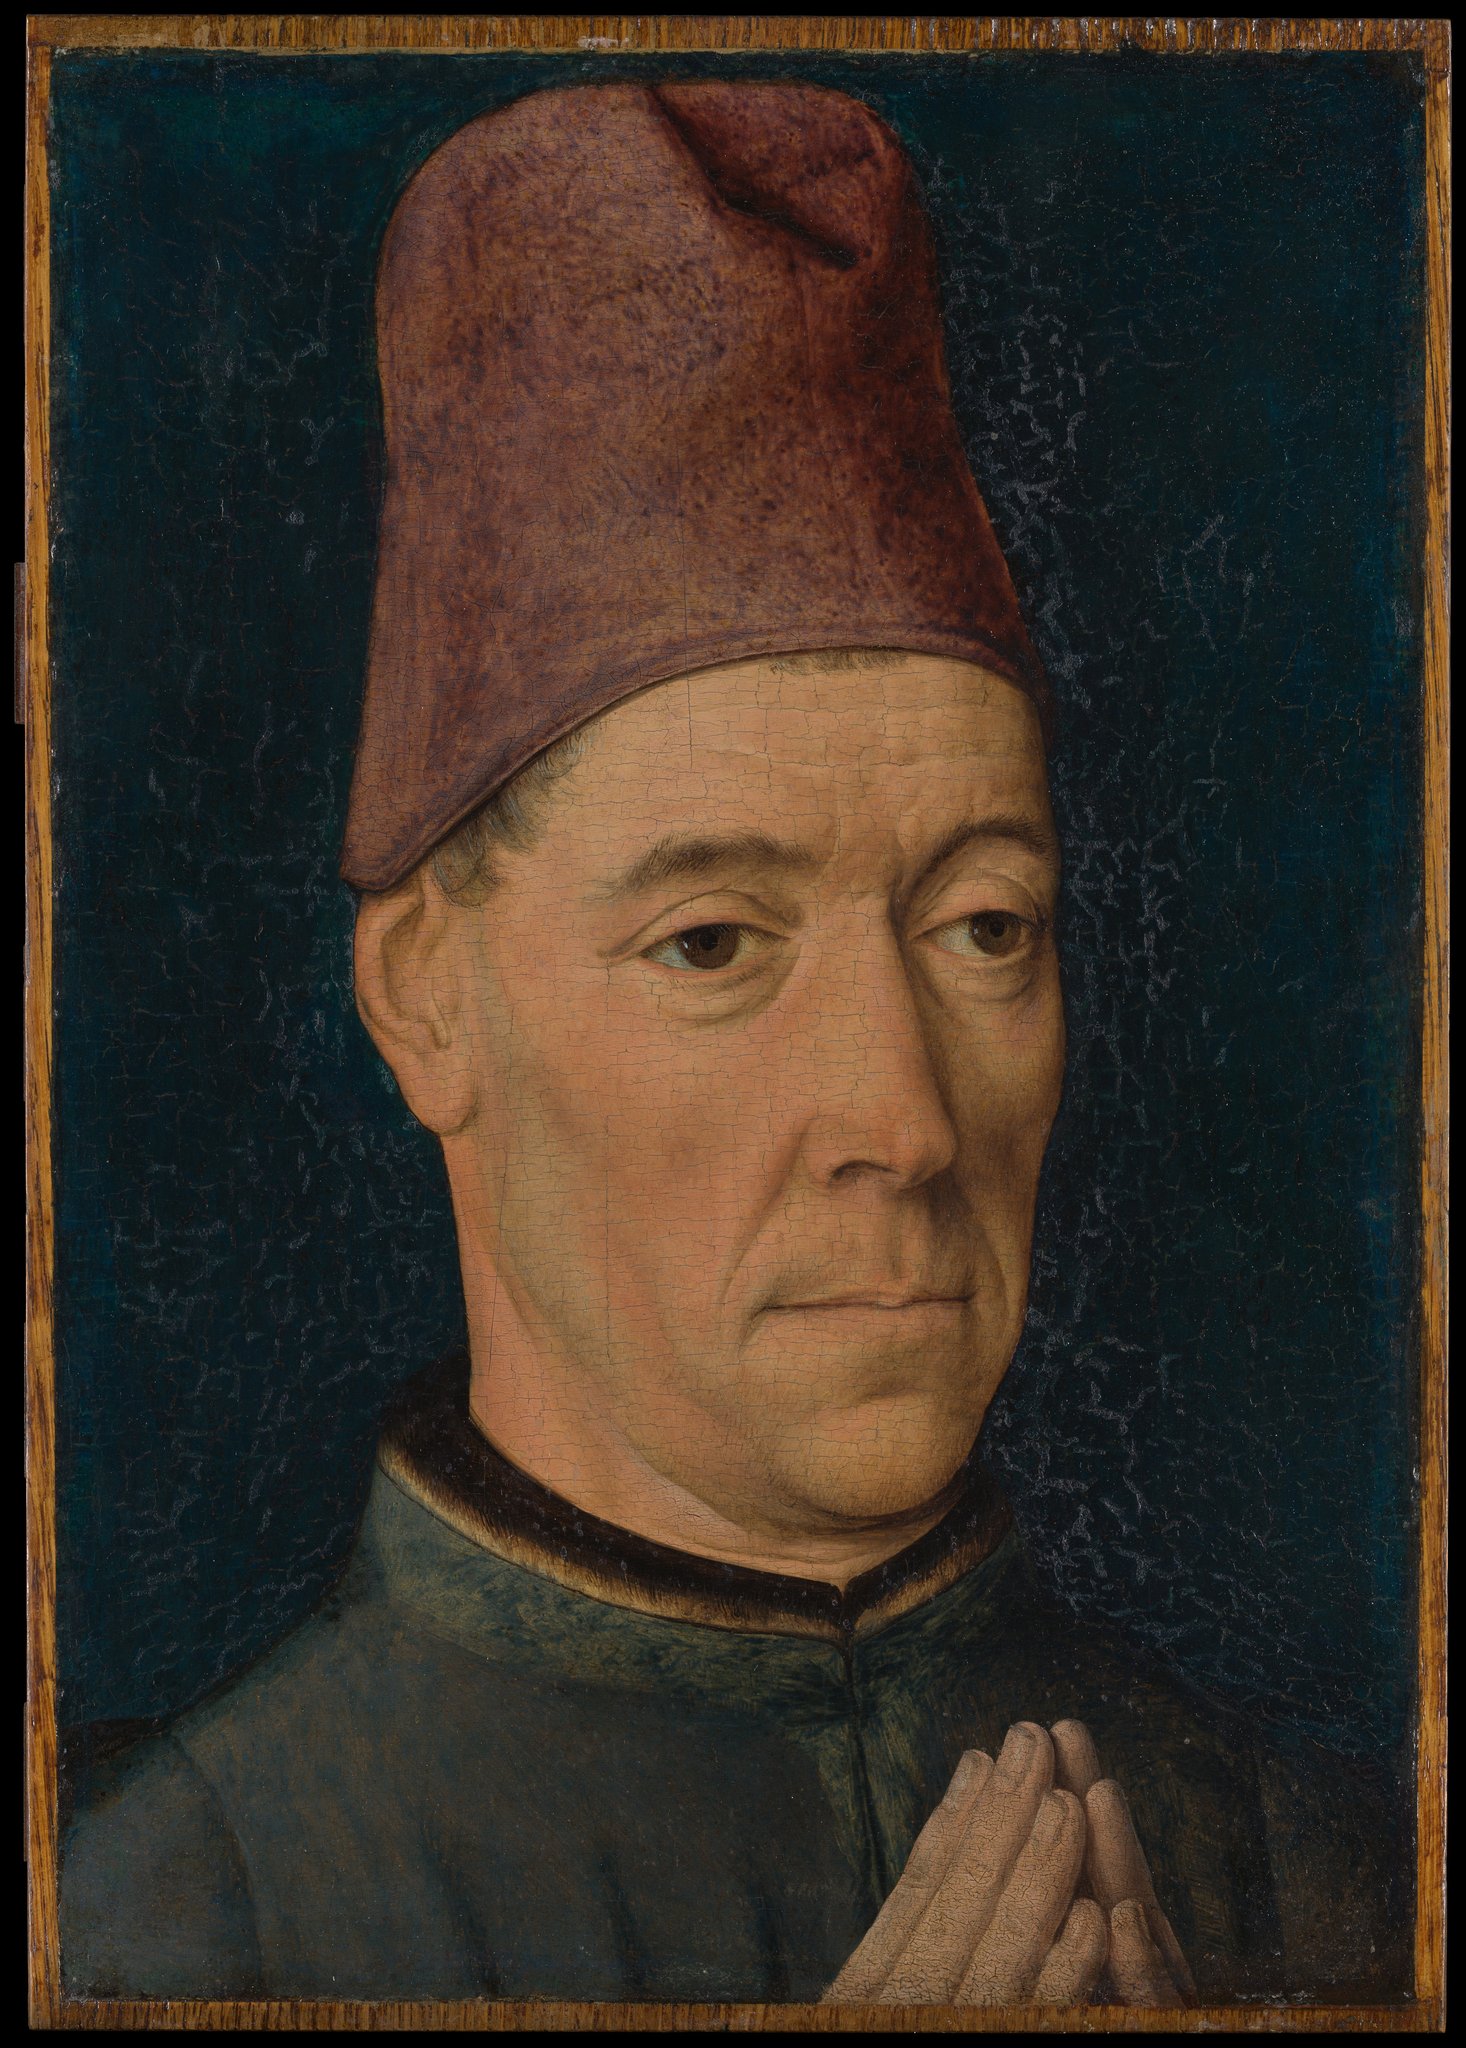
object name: painting fragment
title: Portrait of a Man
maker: dieric bouts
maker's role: artist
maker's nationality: netherlandish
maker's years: 1457-1475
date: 1470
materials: oil, wood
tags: men,portraits